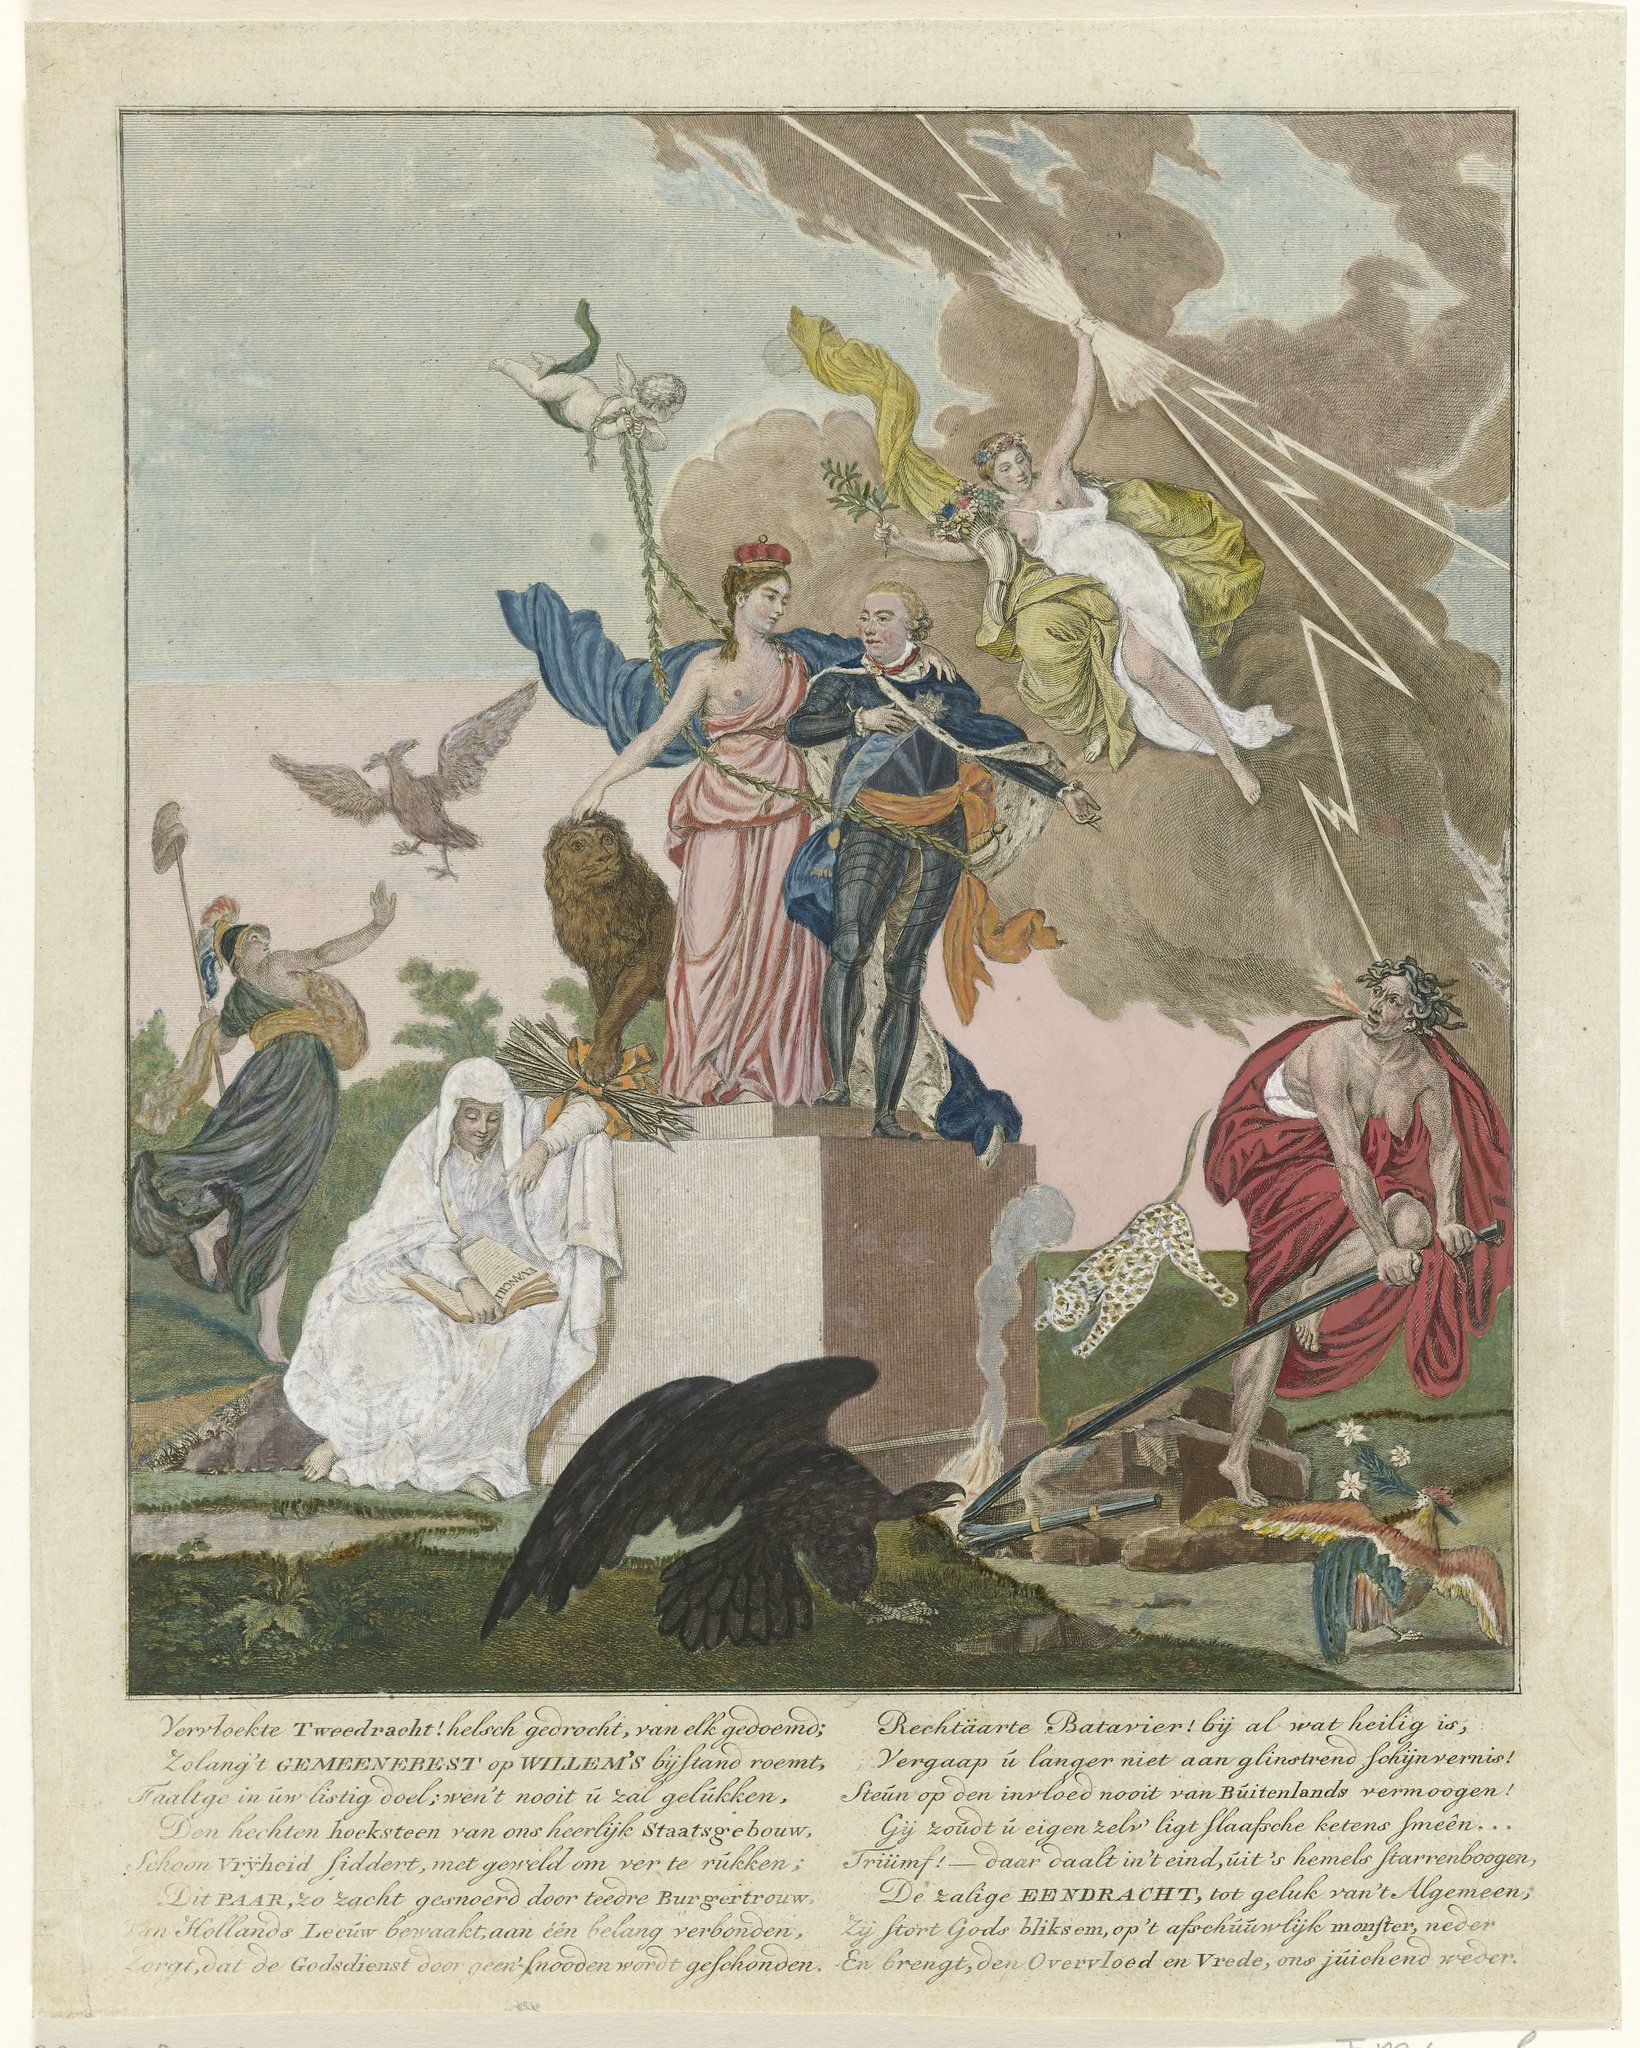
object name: print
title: Allegorie op het herstel van Willem V als stadhouder, 1787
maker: Anonymous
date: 1787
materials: paper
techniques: engraving, etching, hand coloring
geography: northern netherlands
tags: the hague, william v (prince of orange), personifications of countries, nations, states, districts, etc., disagreement, discord; 'discordia' (ripa) (+ abstract concept represented by female figure), agreement, unity; 'concordia', 'concordia insuperabile', 'concordia militare', 'concordia di pace', 'unione civile' (ripa) (+ abstract concept represented by female figure), netherlands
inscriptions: collector's mark: Lugt 2228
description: Orangistische allegorie op het herstel van stadhouder Willem V in 1787. De stadhouder staande op een hoeksteen met de Nederlandse Maagd en Leeuw. Tweedracht probeert tevergeefs de hoeksteen van het Staatsgebouw omver te werpen. Een Pruisische adelaar verjaaagt de Franse haan en de Engelse panter. De Eendracht laat vanuit de hemel bliksemschichten neerdalen op de Tweedracht. Met onderschrift in twee kolommen. Bij de prent behoort ook een afzonderlijke verklaring.